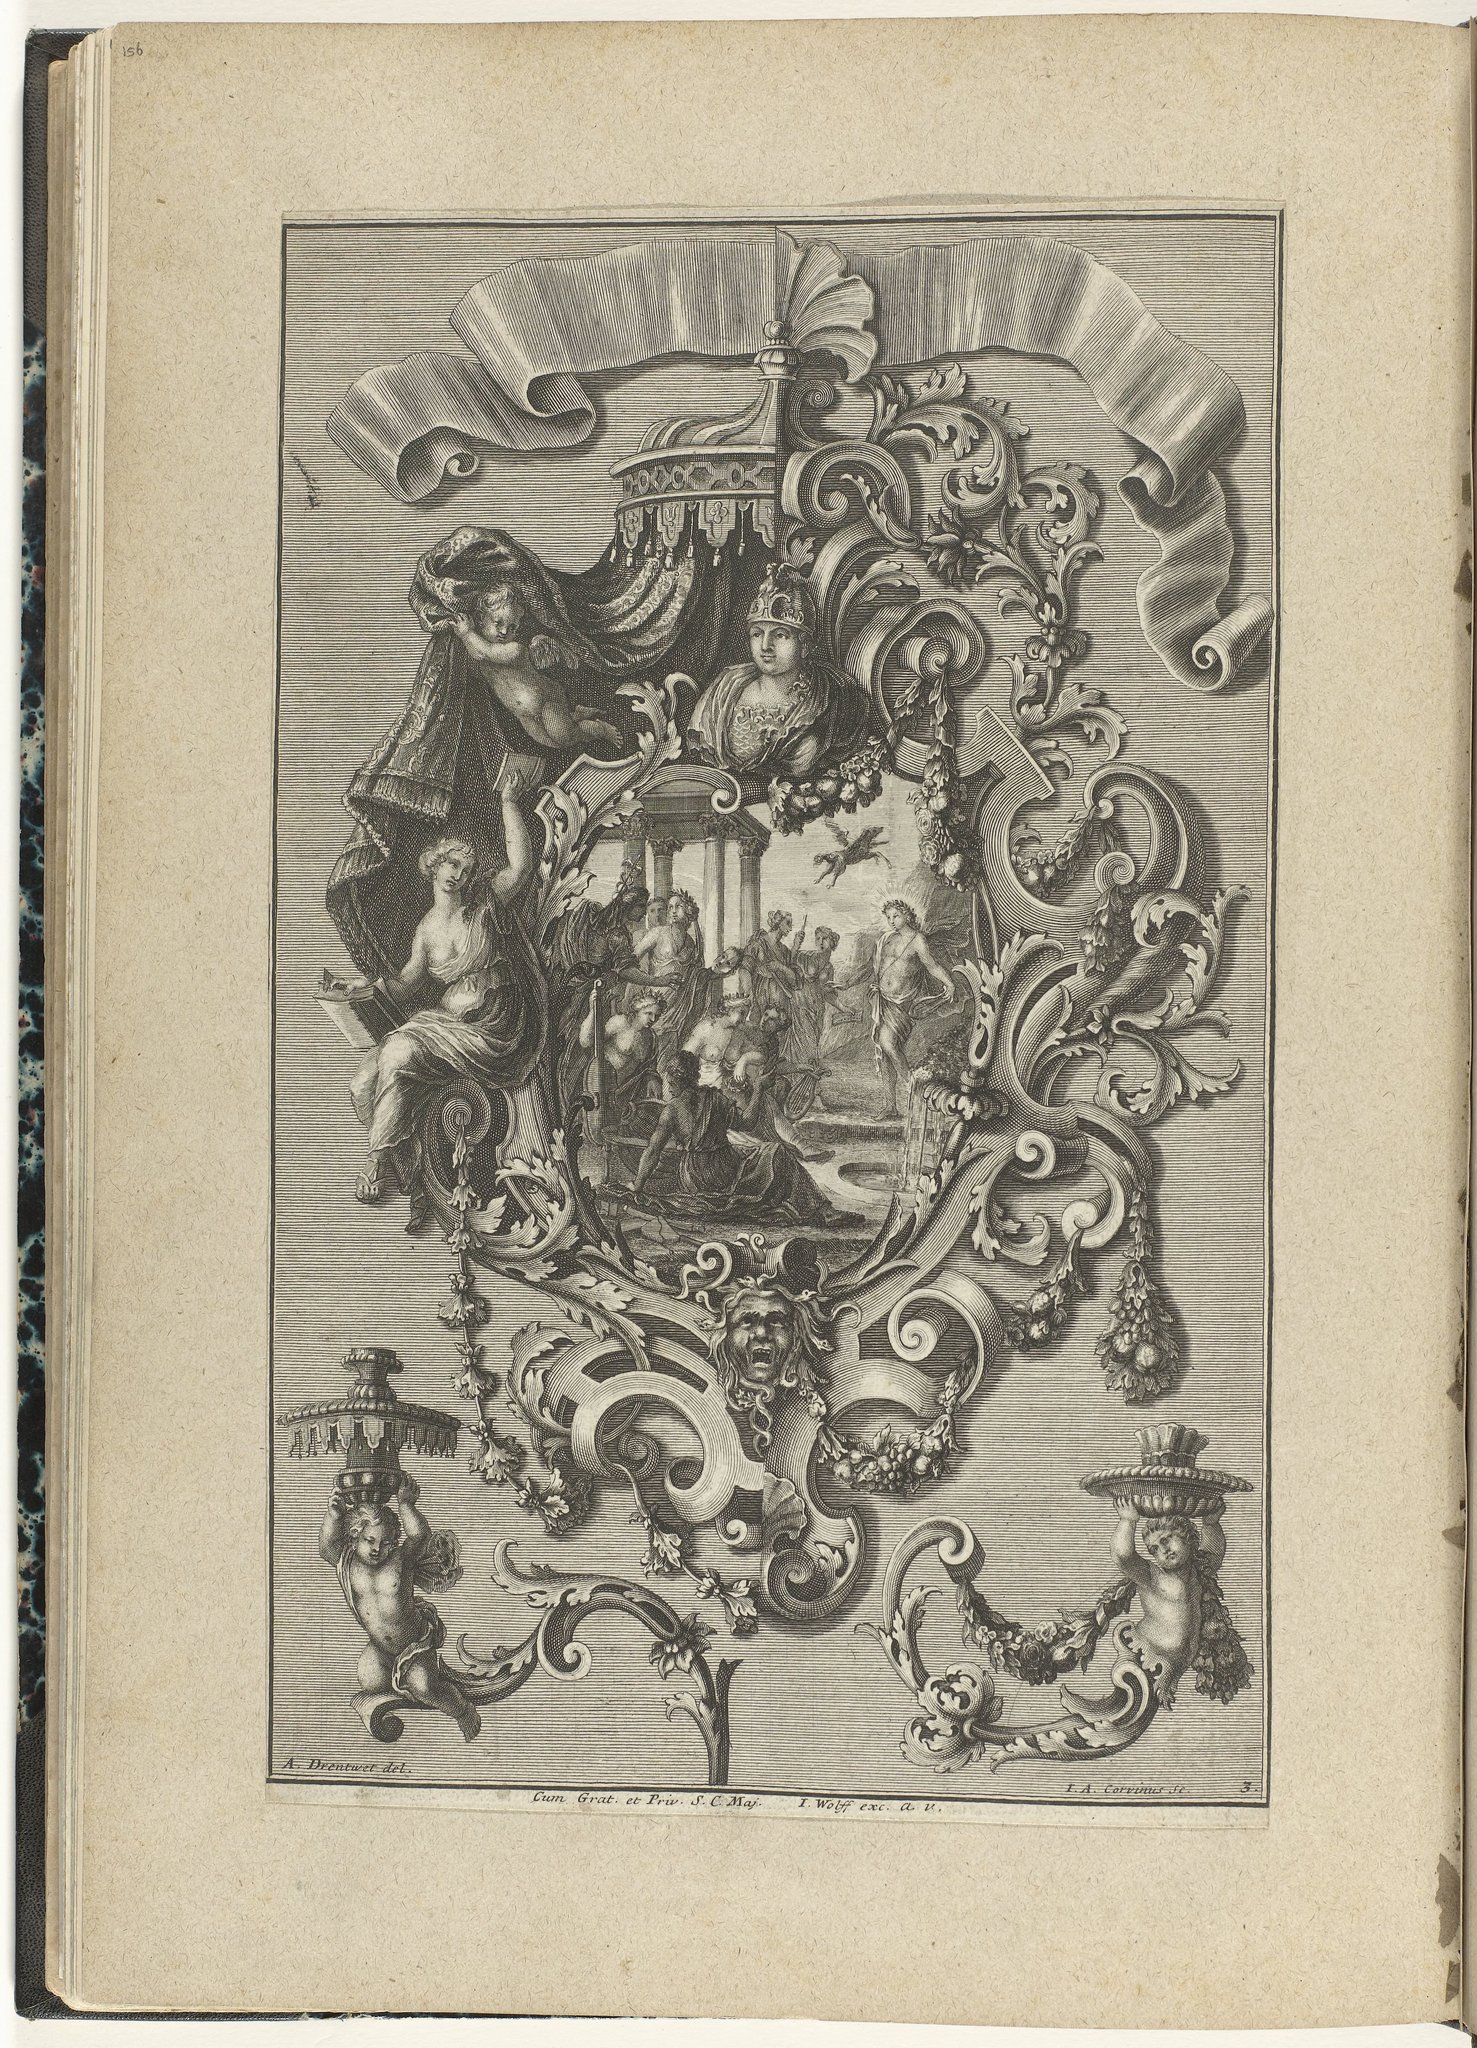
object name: print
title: Cartouche met Apollo en de muzen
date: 1693-1738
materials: paper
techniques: engraving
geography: germany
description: Cartouche van rolwerk met een variant voor de rechterhelft, linksboven hangt een baldakijn, onderaan het hoofd van Medusa. Links- en rechtsonder bevinden zich twee wandarmen (?) opgebouwd uit putti.